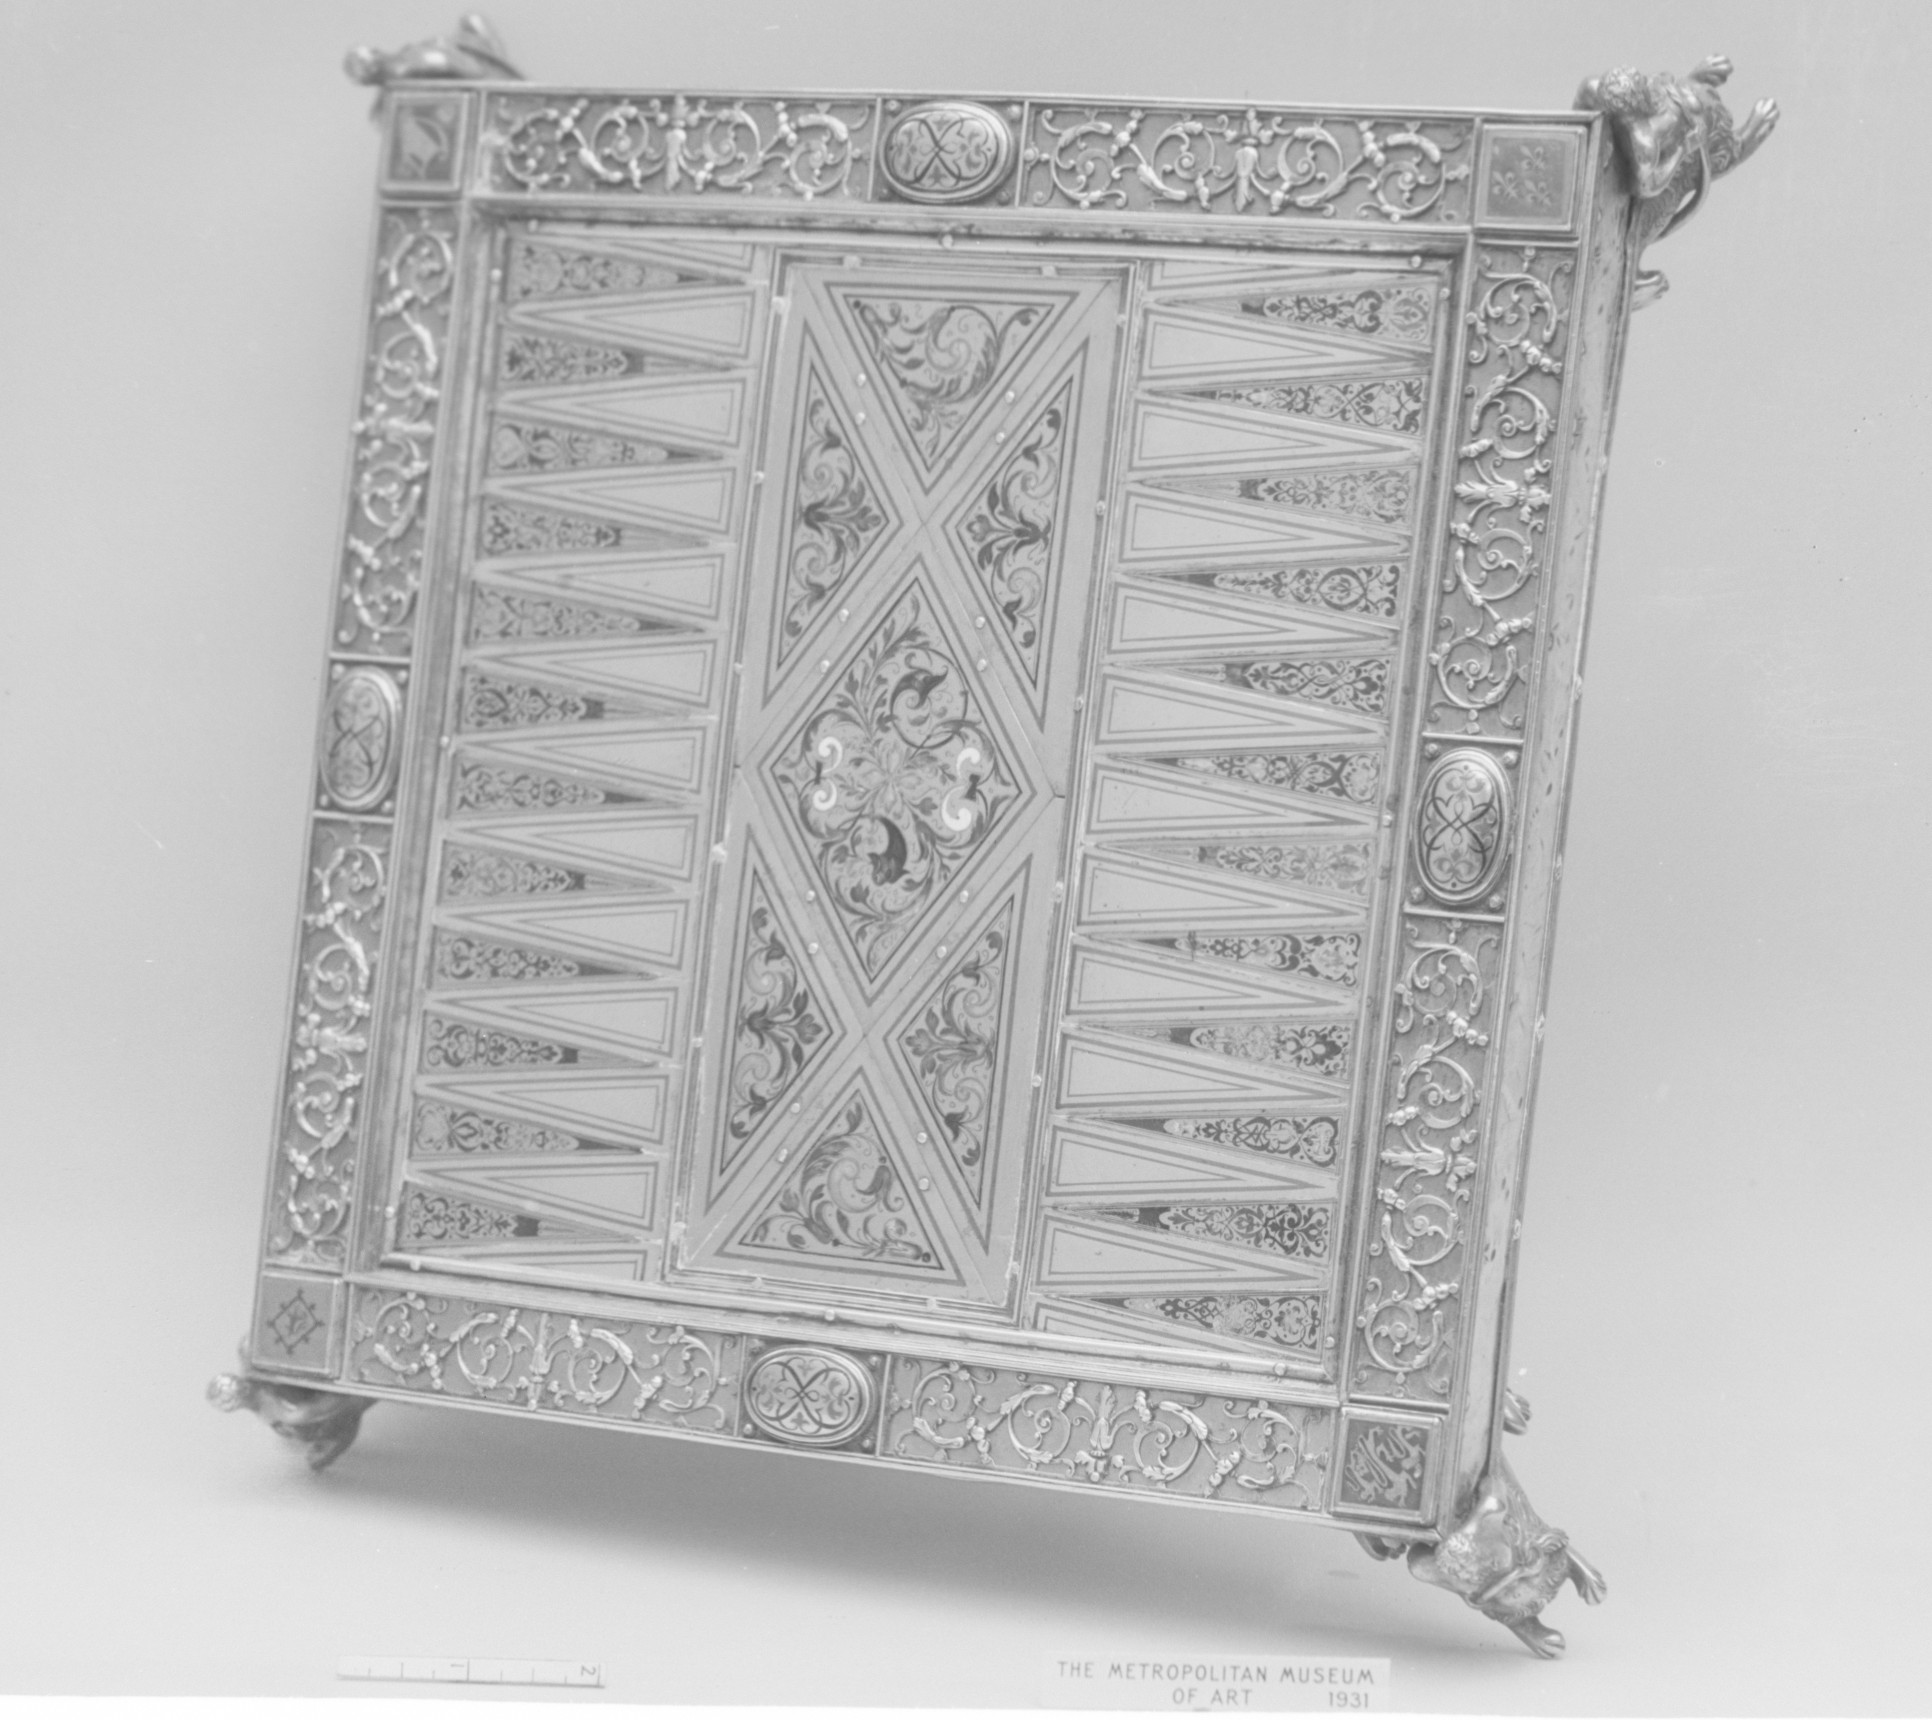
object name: tric trac board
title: Tric-trac board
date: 1550-1575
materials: enamel, silver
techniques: enamel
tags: games